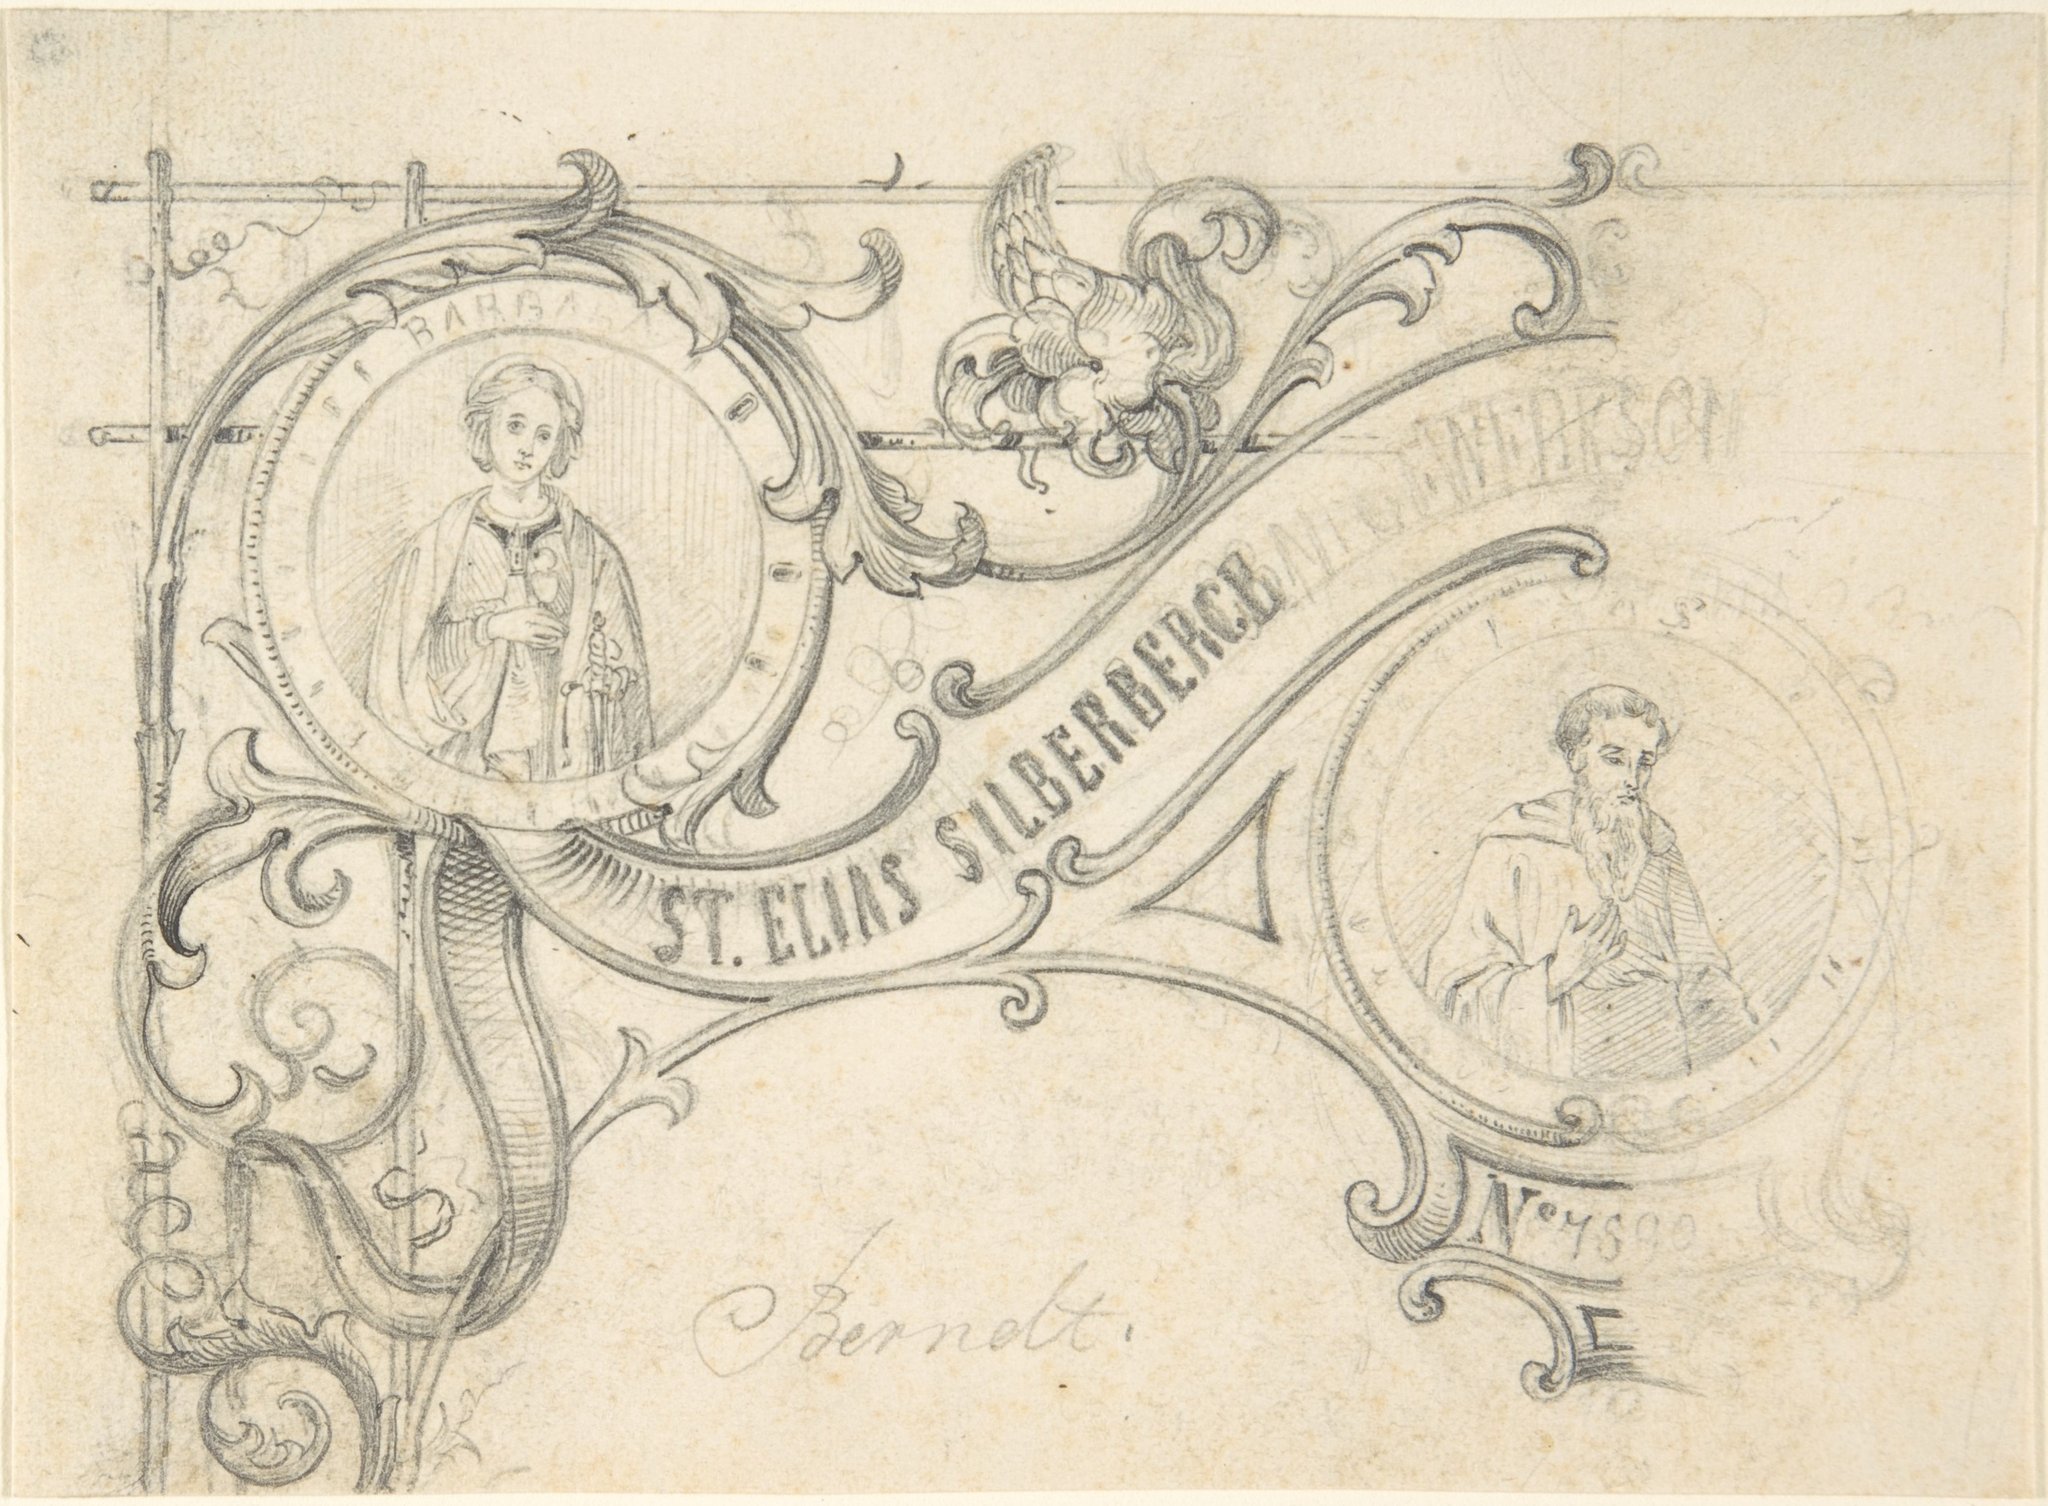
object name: drawing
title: Design for Ticket or an Invitation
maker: anonymous, german, 19th century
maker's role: artist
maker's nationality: german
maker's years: 1800-1899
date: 1801-1900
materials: graphite, ink, paper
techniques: pen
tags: ornament,men,portraits,women